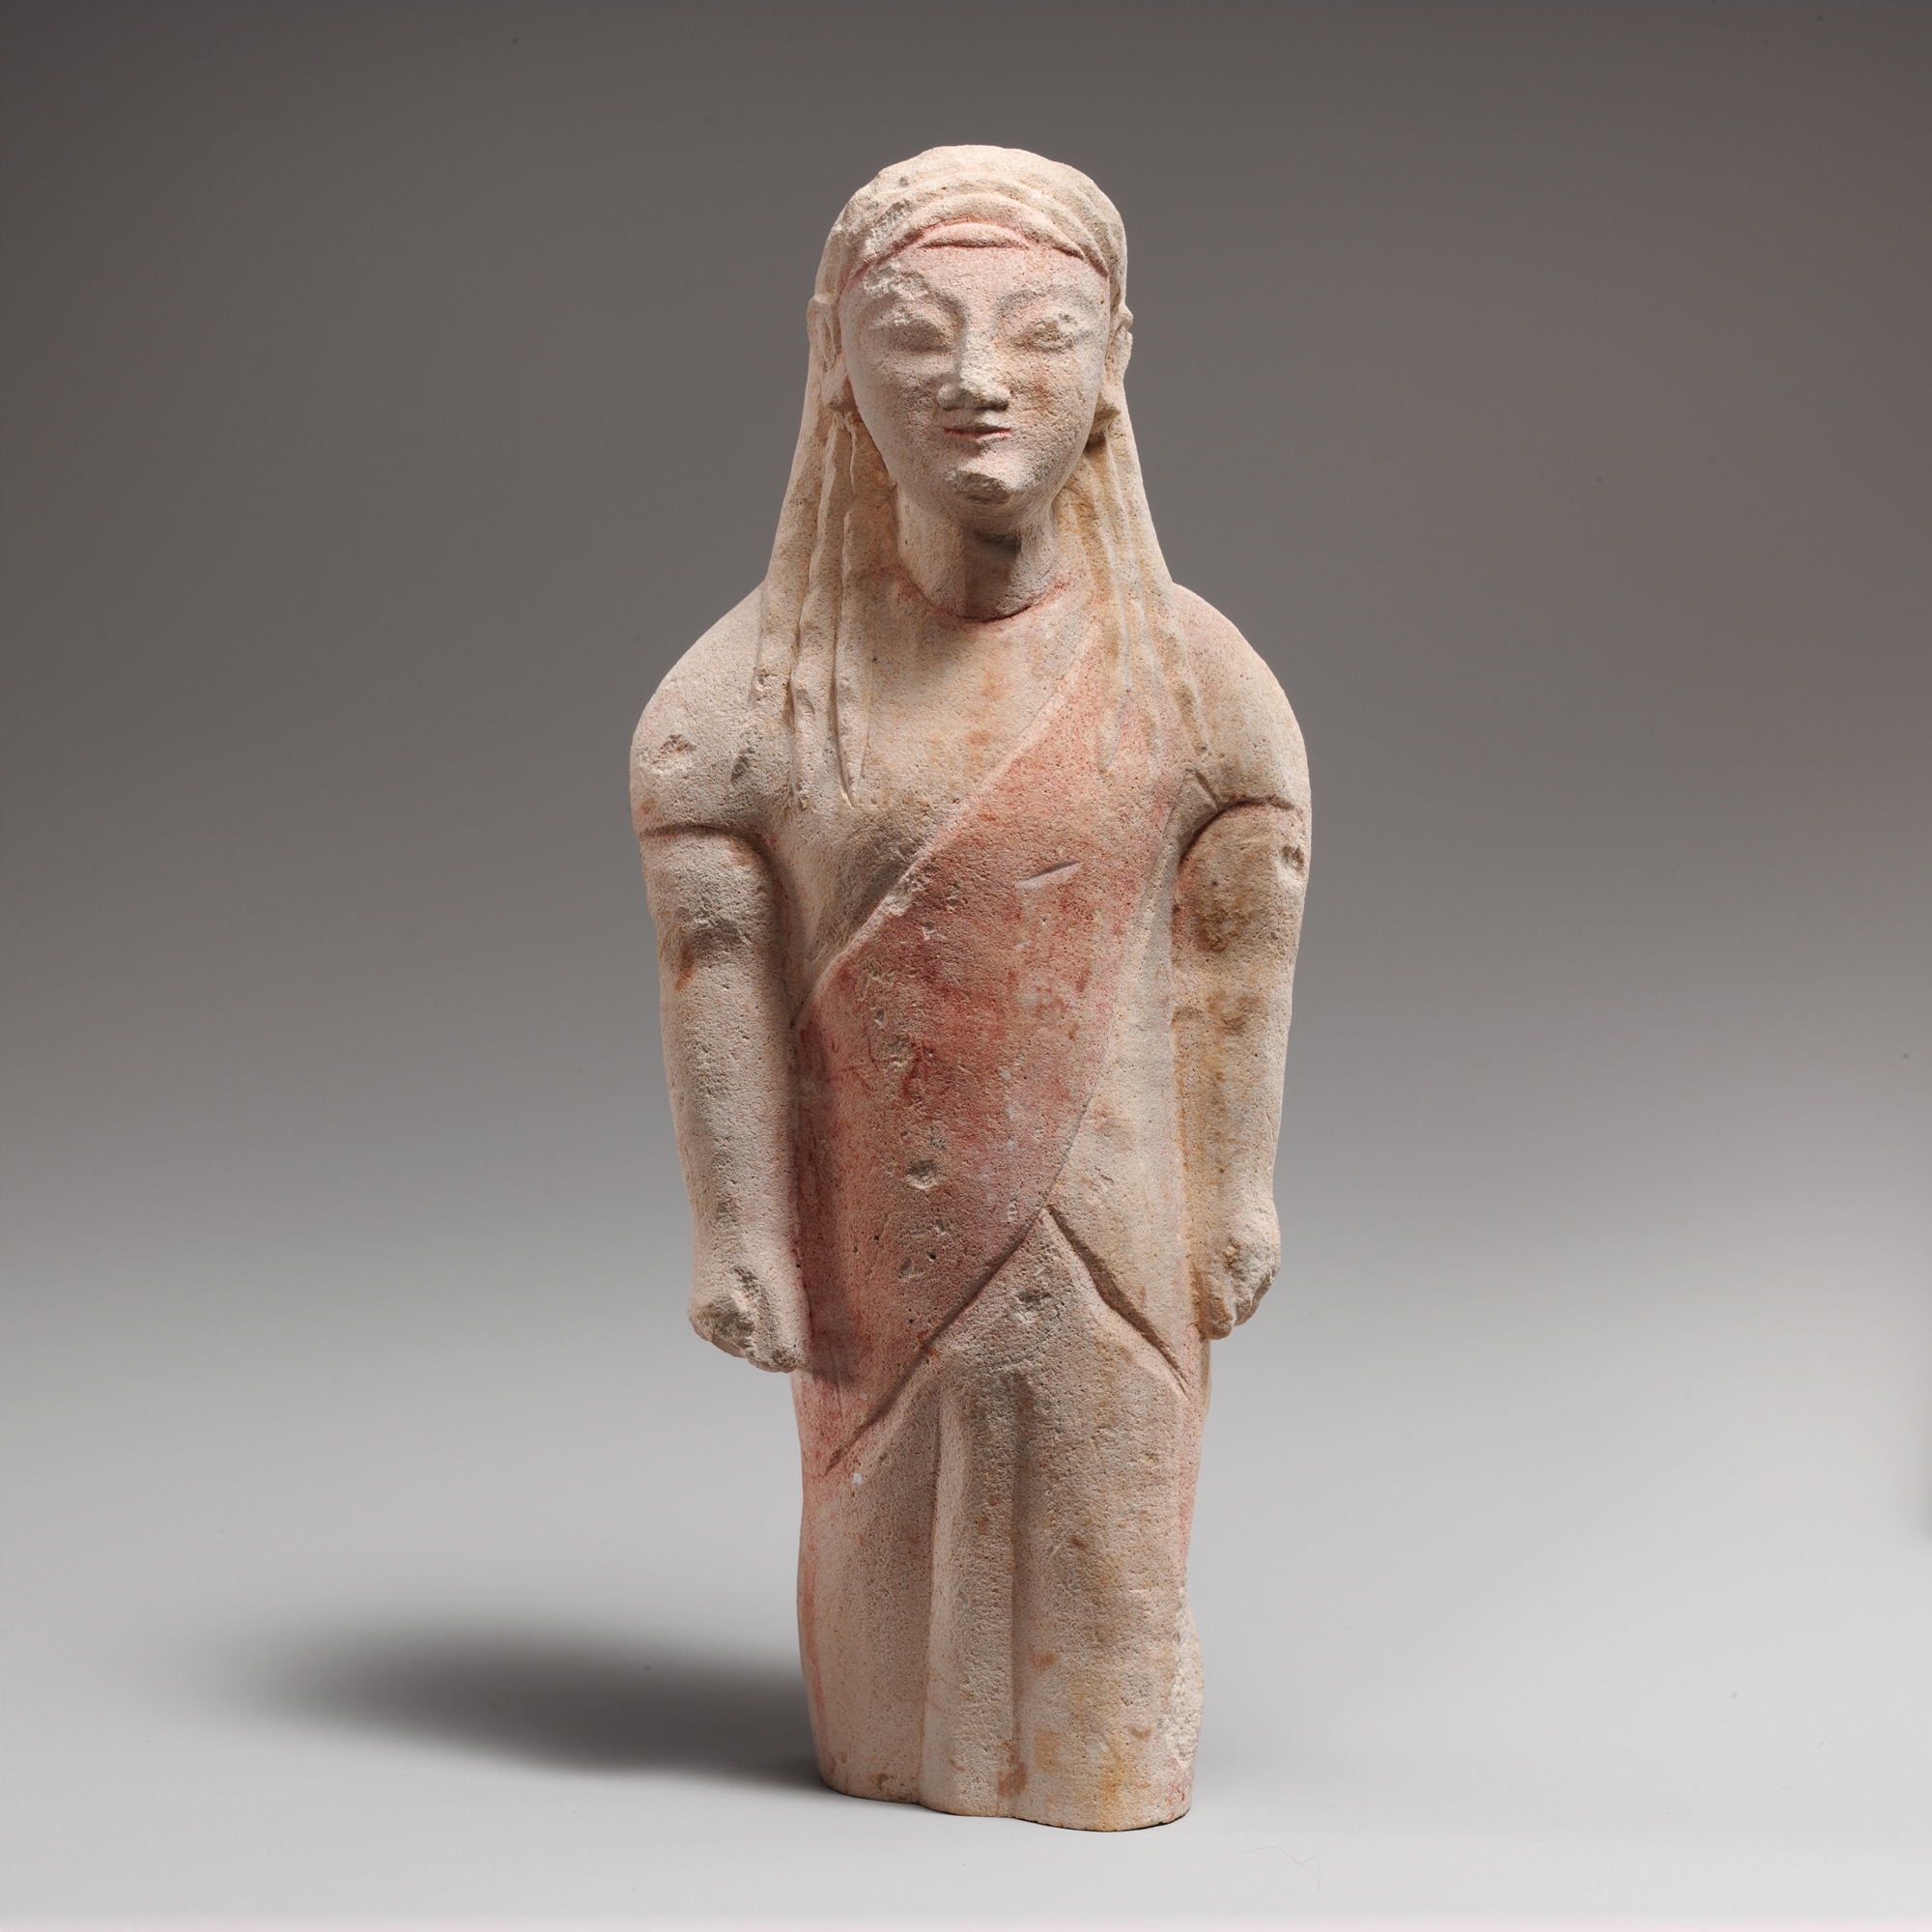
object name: statuette of a youth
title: Limestone statuette of beardless male votary in Greek dress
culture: cypriot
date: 567-535 BCE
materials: limestone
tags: men